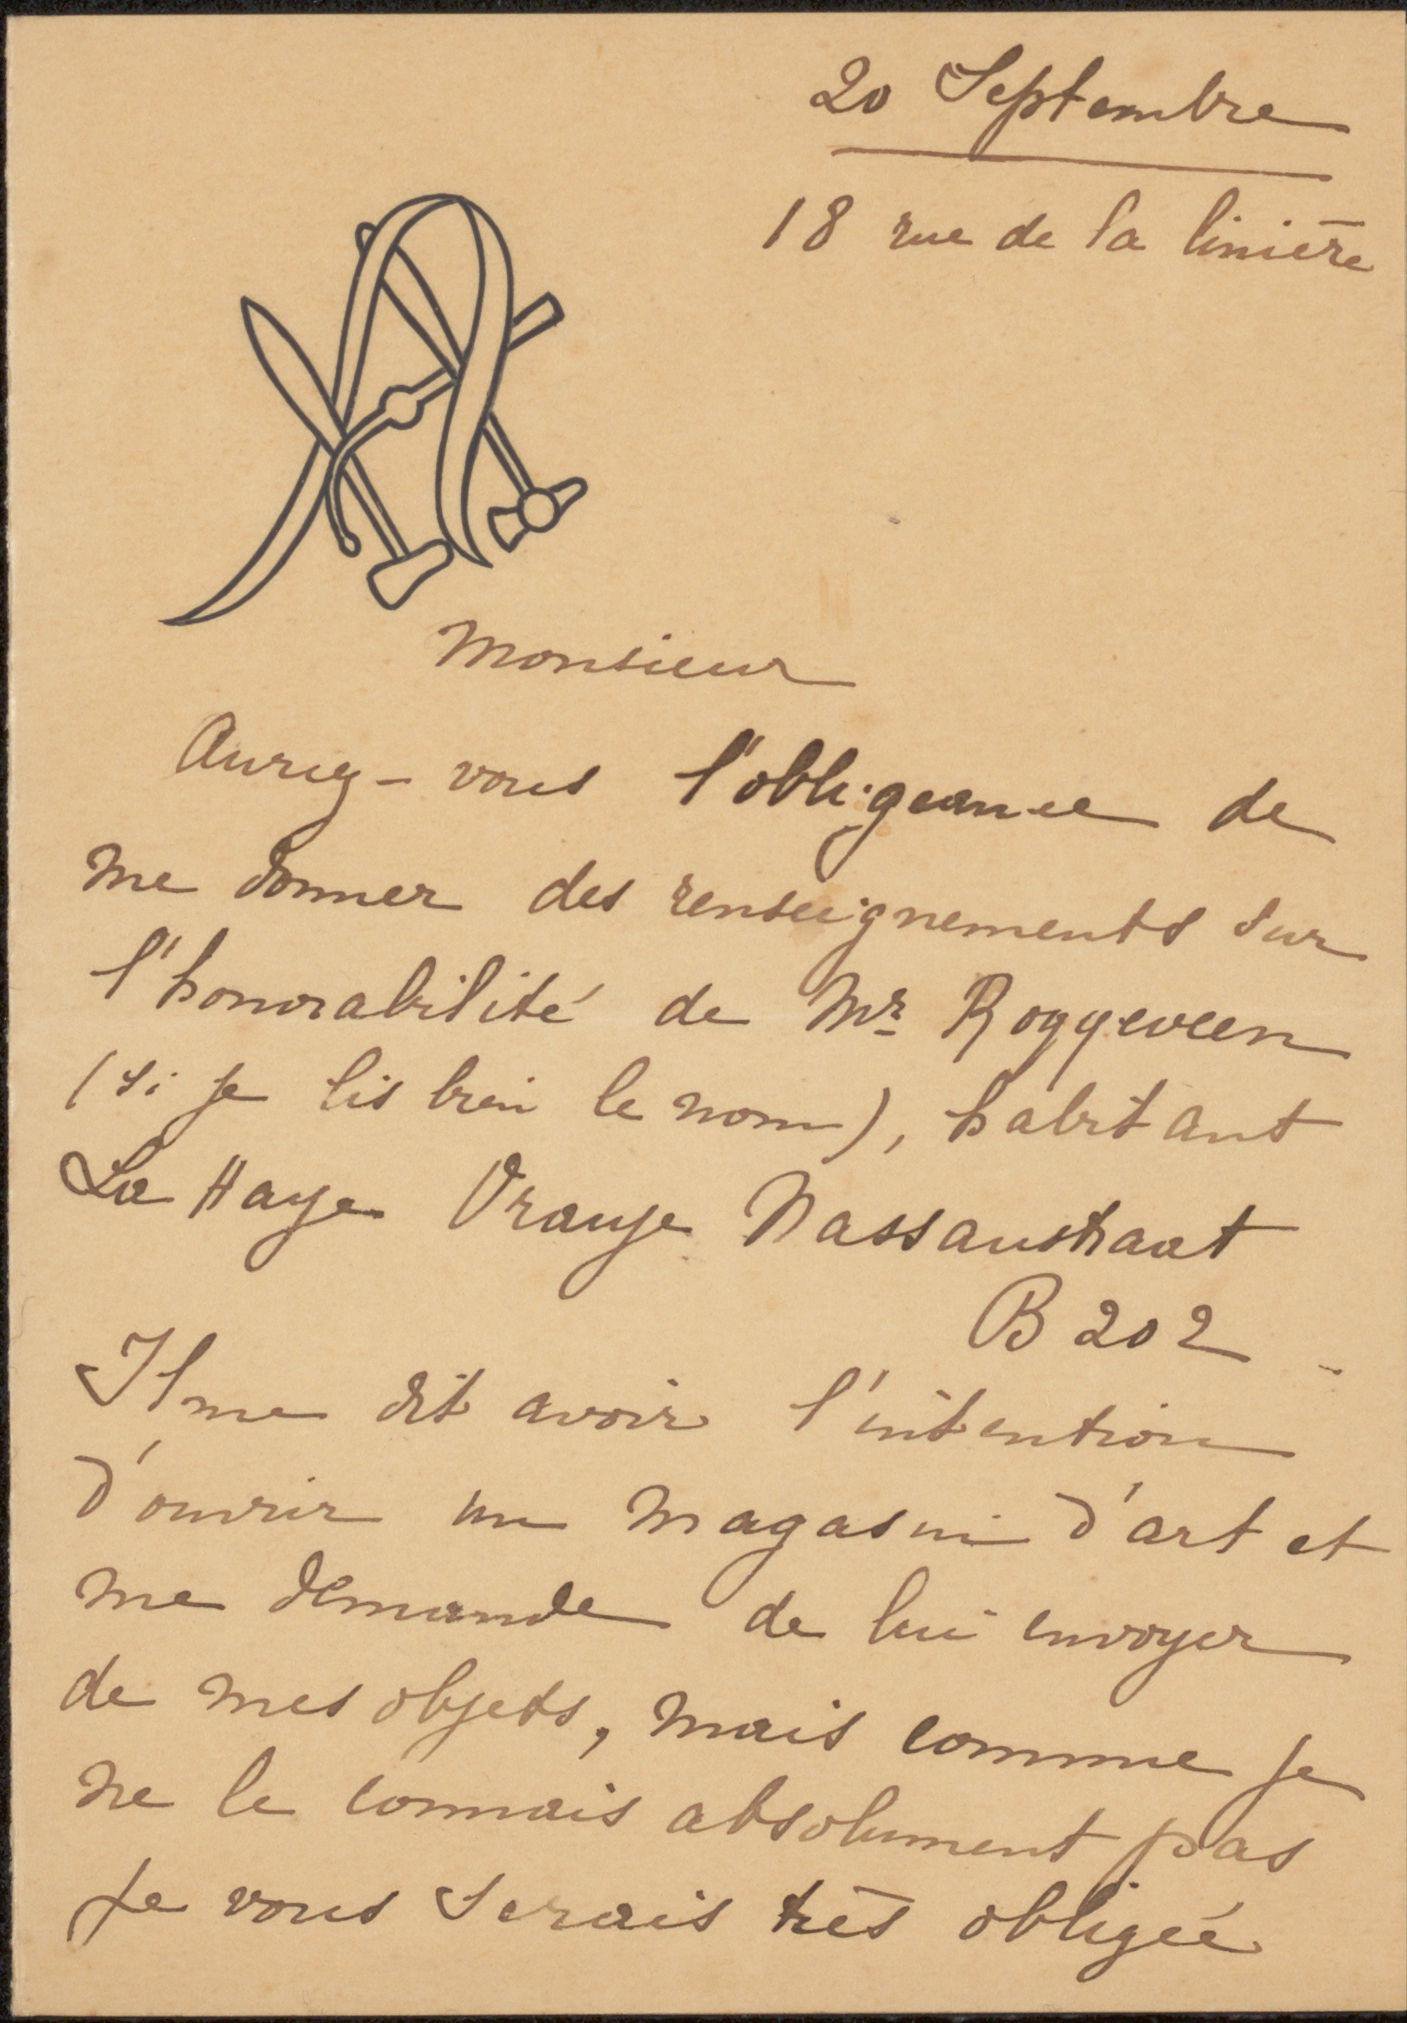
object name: letter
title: Brief aan Philip Zilcken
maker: alice holbach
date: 1901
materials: ink, paper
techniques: pen, printing, writing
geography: brussels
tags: painter, draughtsman, philip zilcken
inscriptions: monogram: ‘AH’, collector's mark: ‘RPK’